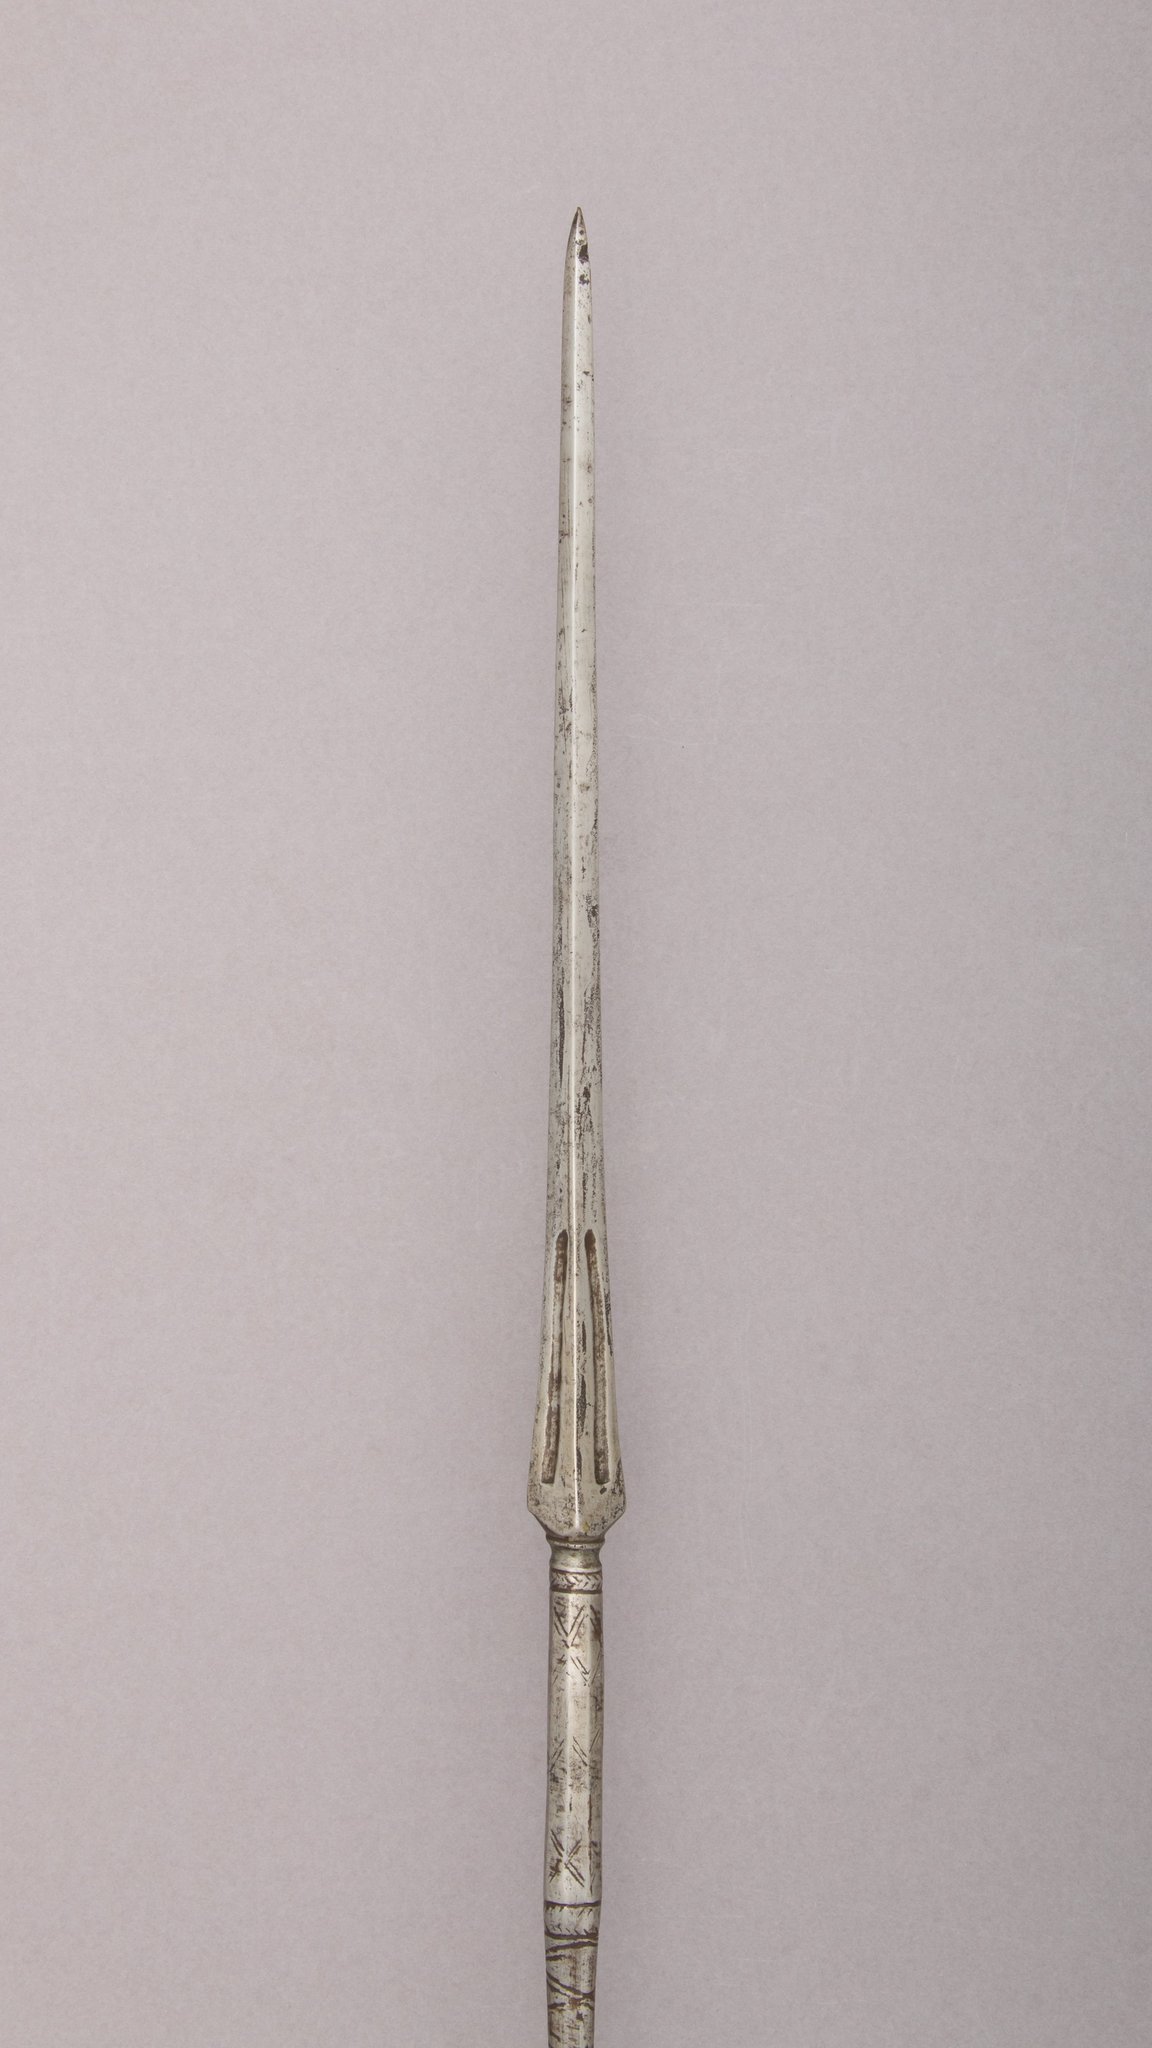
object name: spear sangu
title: Spear (Sangu)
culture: indian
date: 1701-1900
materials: steel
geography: india